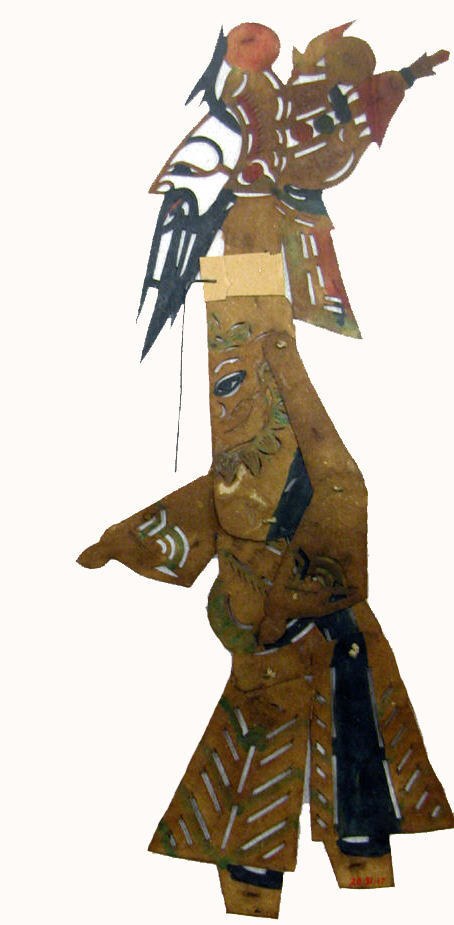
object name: shadow player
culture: chinese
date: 1801-1900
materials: cord, skin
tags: human figures